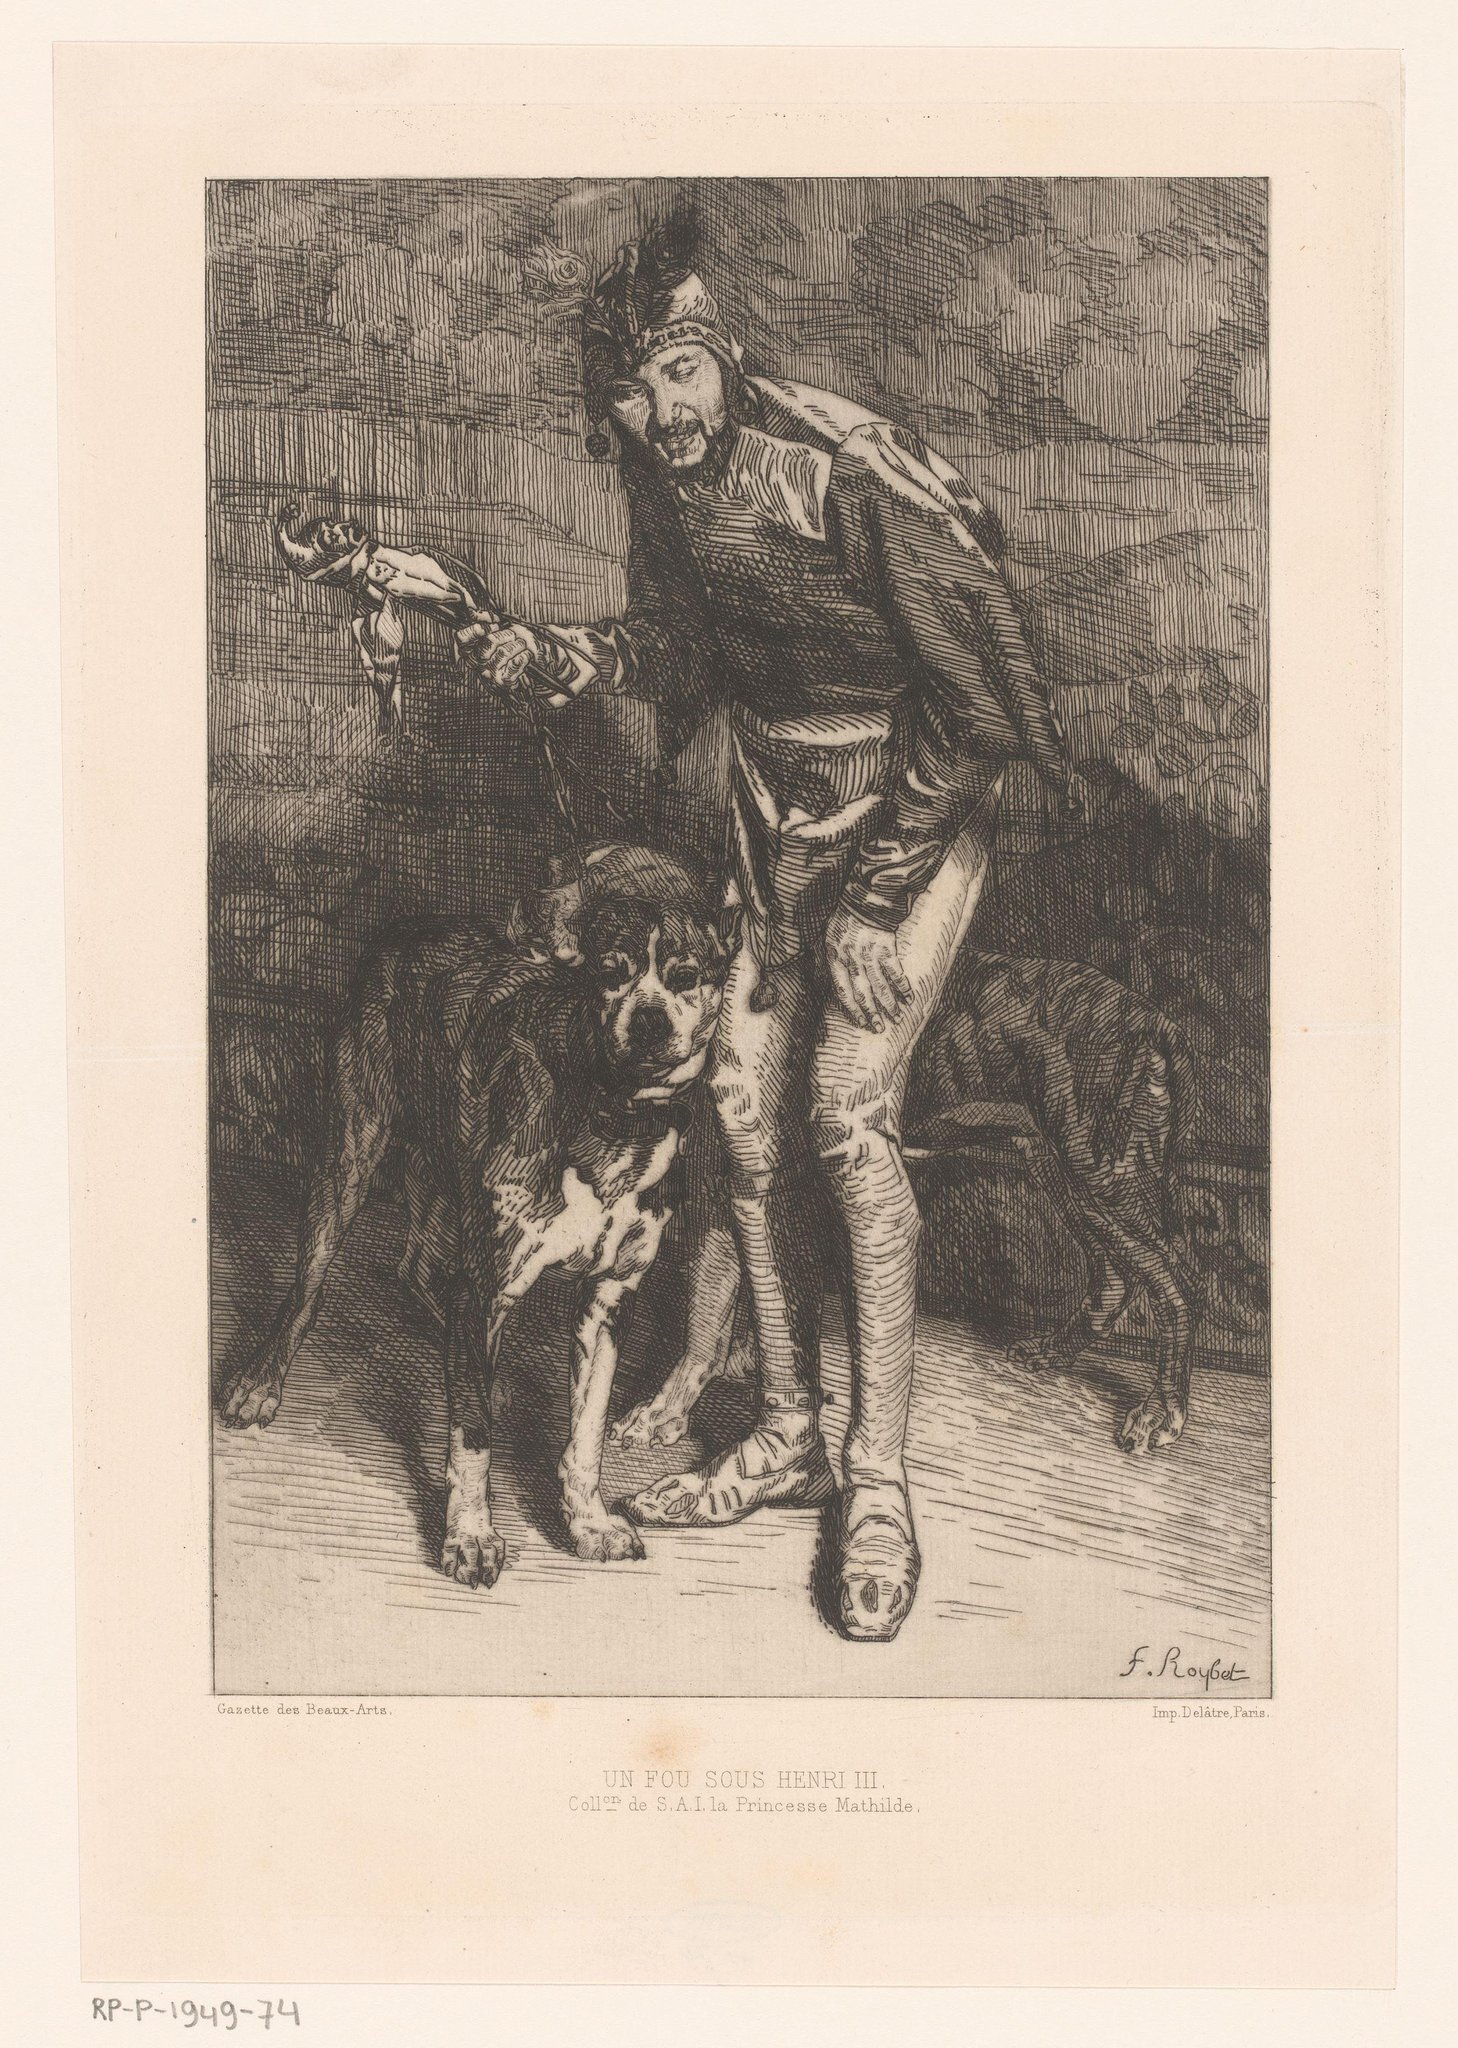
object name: print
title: Un fou sous Henri IV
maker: ferdinand roybet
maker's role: draughtsman, print maker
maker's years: 1840-1920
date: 1850-1920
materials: paper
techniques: drypoint, etching, intaglio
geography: paris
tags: court jester, court fool, dog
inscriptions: collector's mark: Lugt 2228